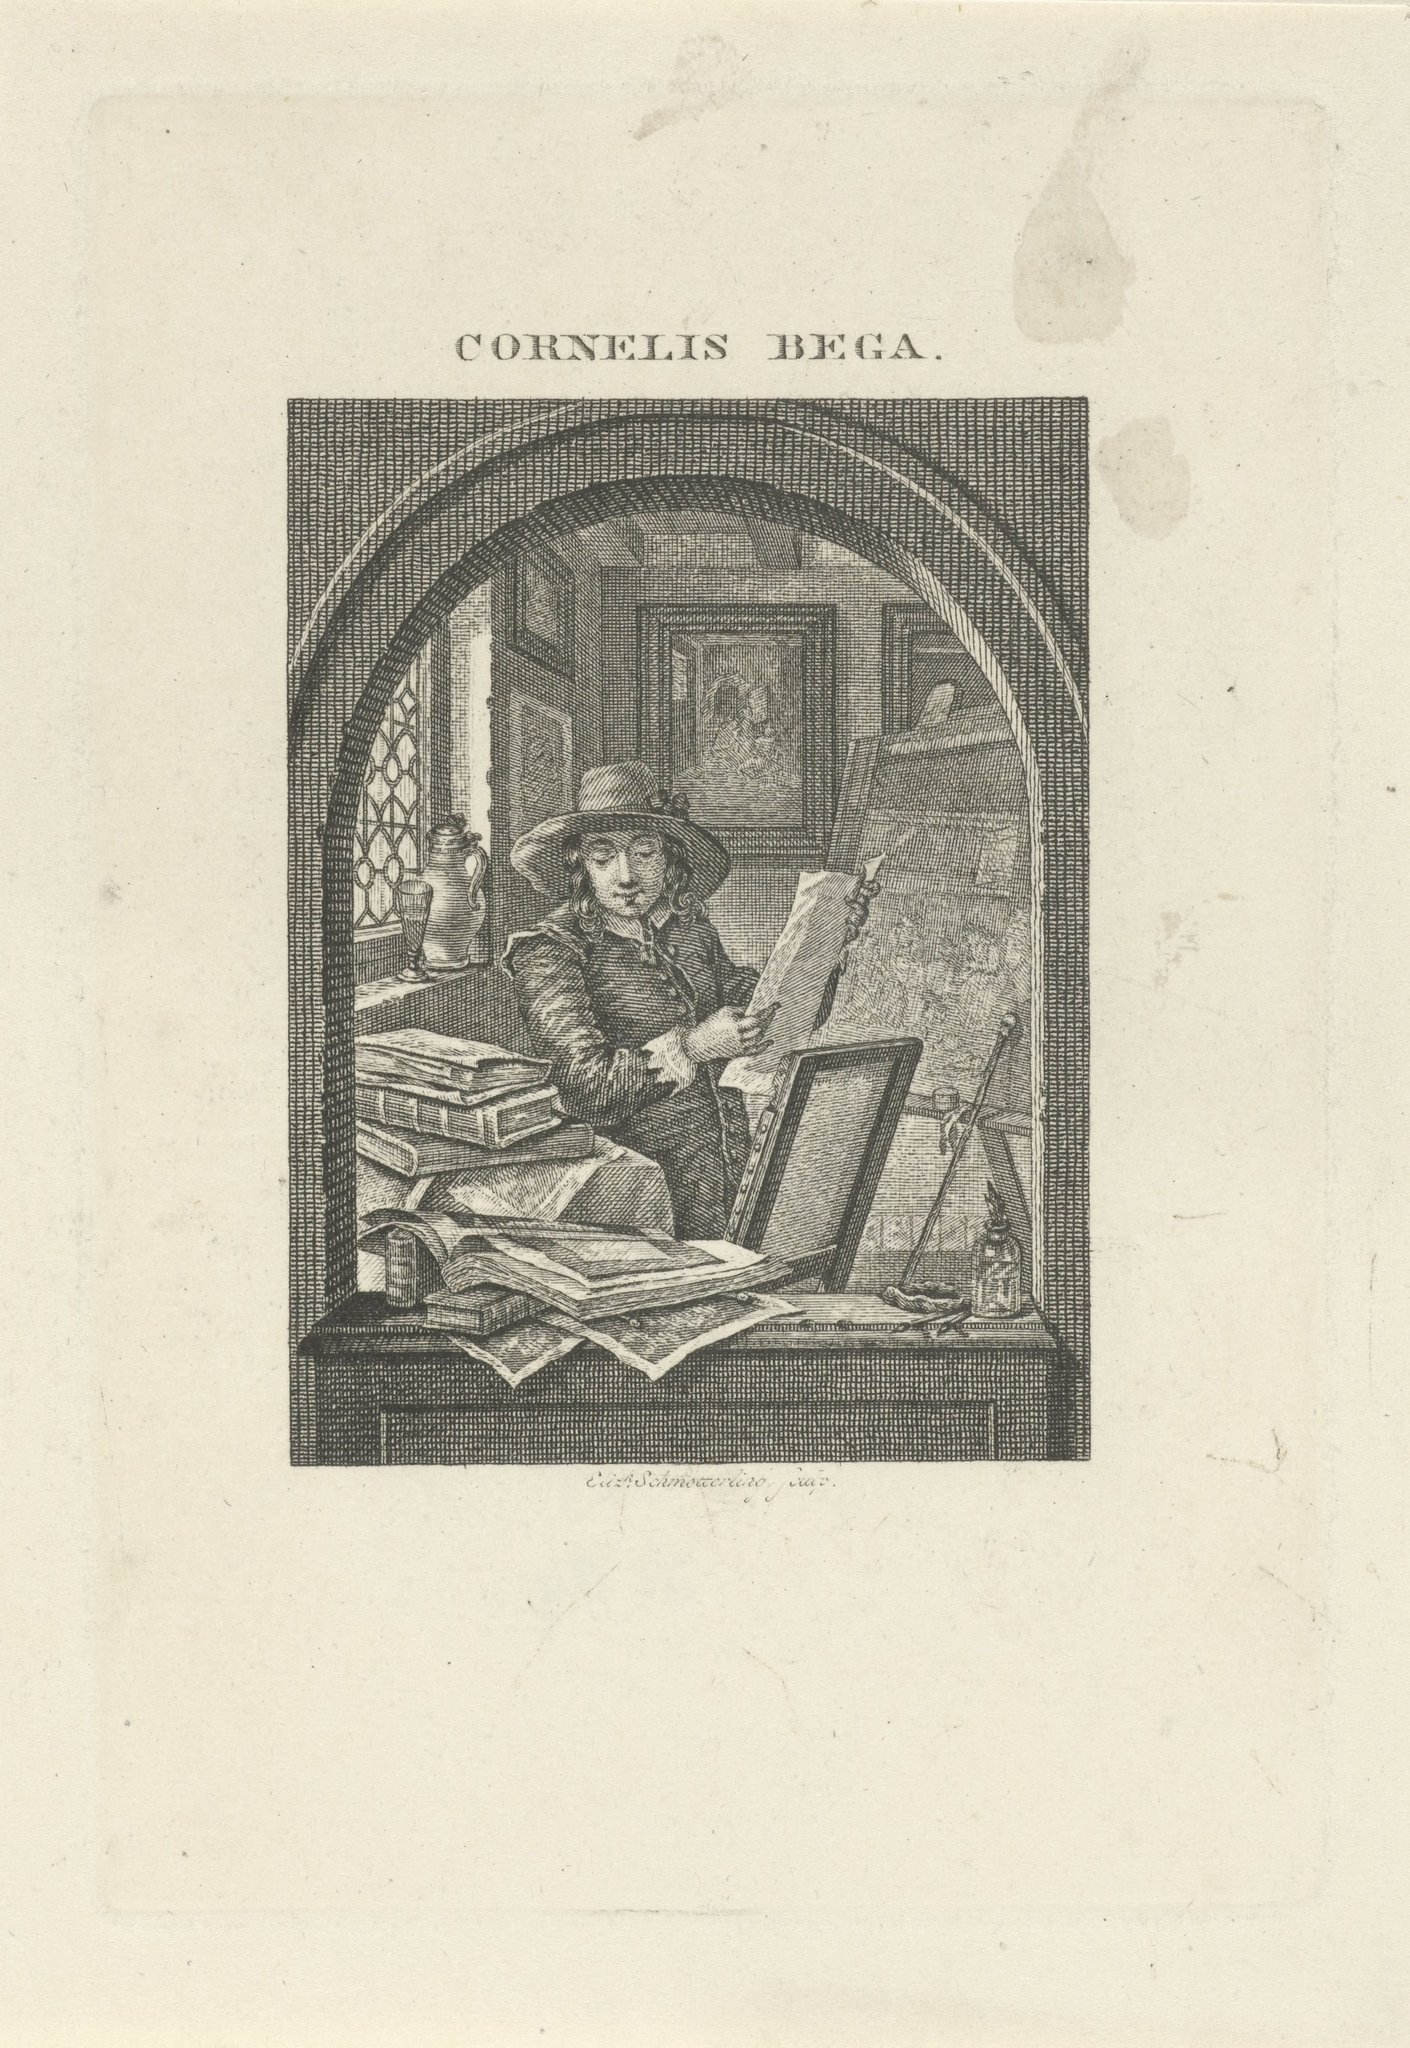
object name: print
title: Schilder in zijn atelier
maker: elisabeth barbara schmetterling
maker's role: draughtsman, print maker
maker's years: 1804-1882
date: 1814-1882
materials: paper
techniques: engraving, etching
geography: netherlands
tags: painter at work, in his studio, picture, painting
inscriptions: collector's mark: Lugt 2228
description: Een schilder in zijn atelier bij zijn schildersezel met in de hand en stuk papier, mogelijk een prent. In het atelier hangen schilderijen en in de raamopening liggen boeken en prenten.